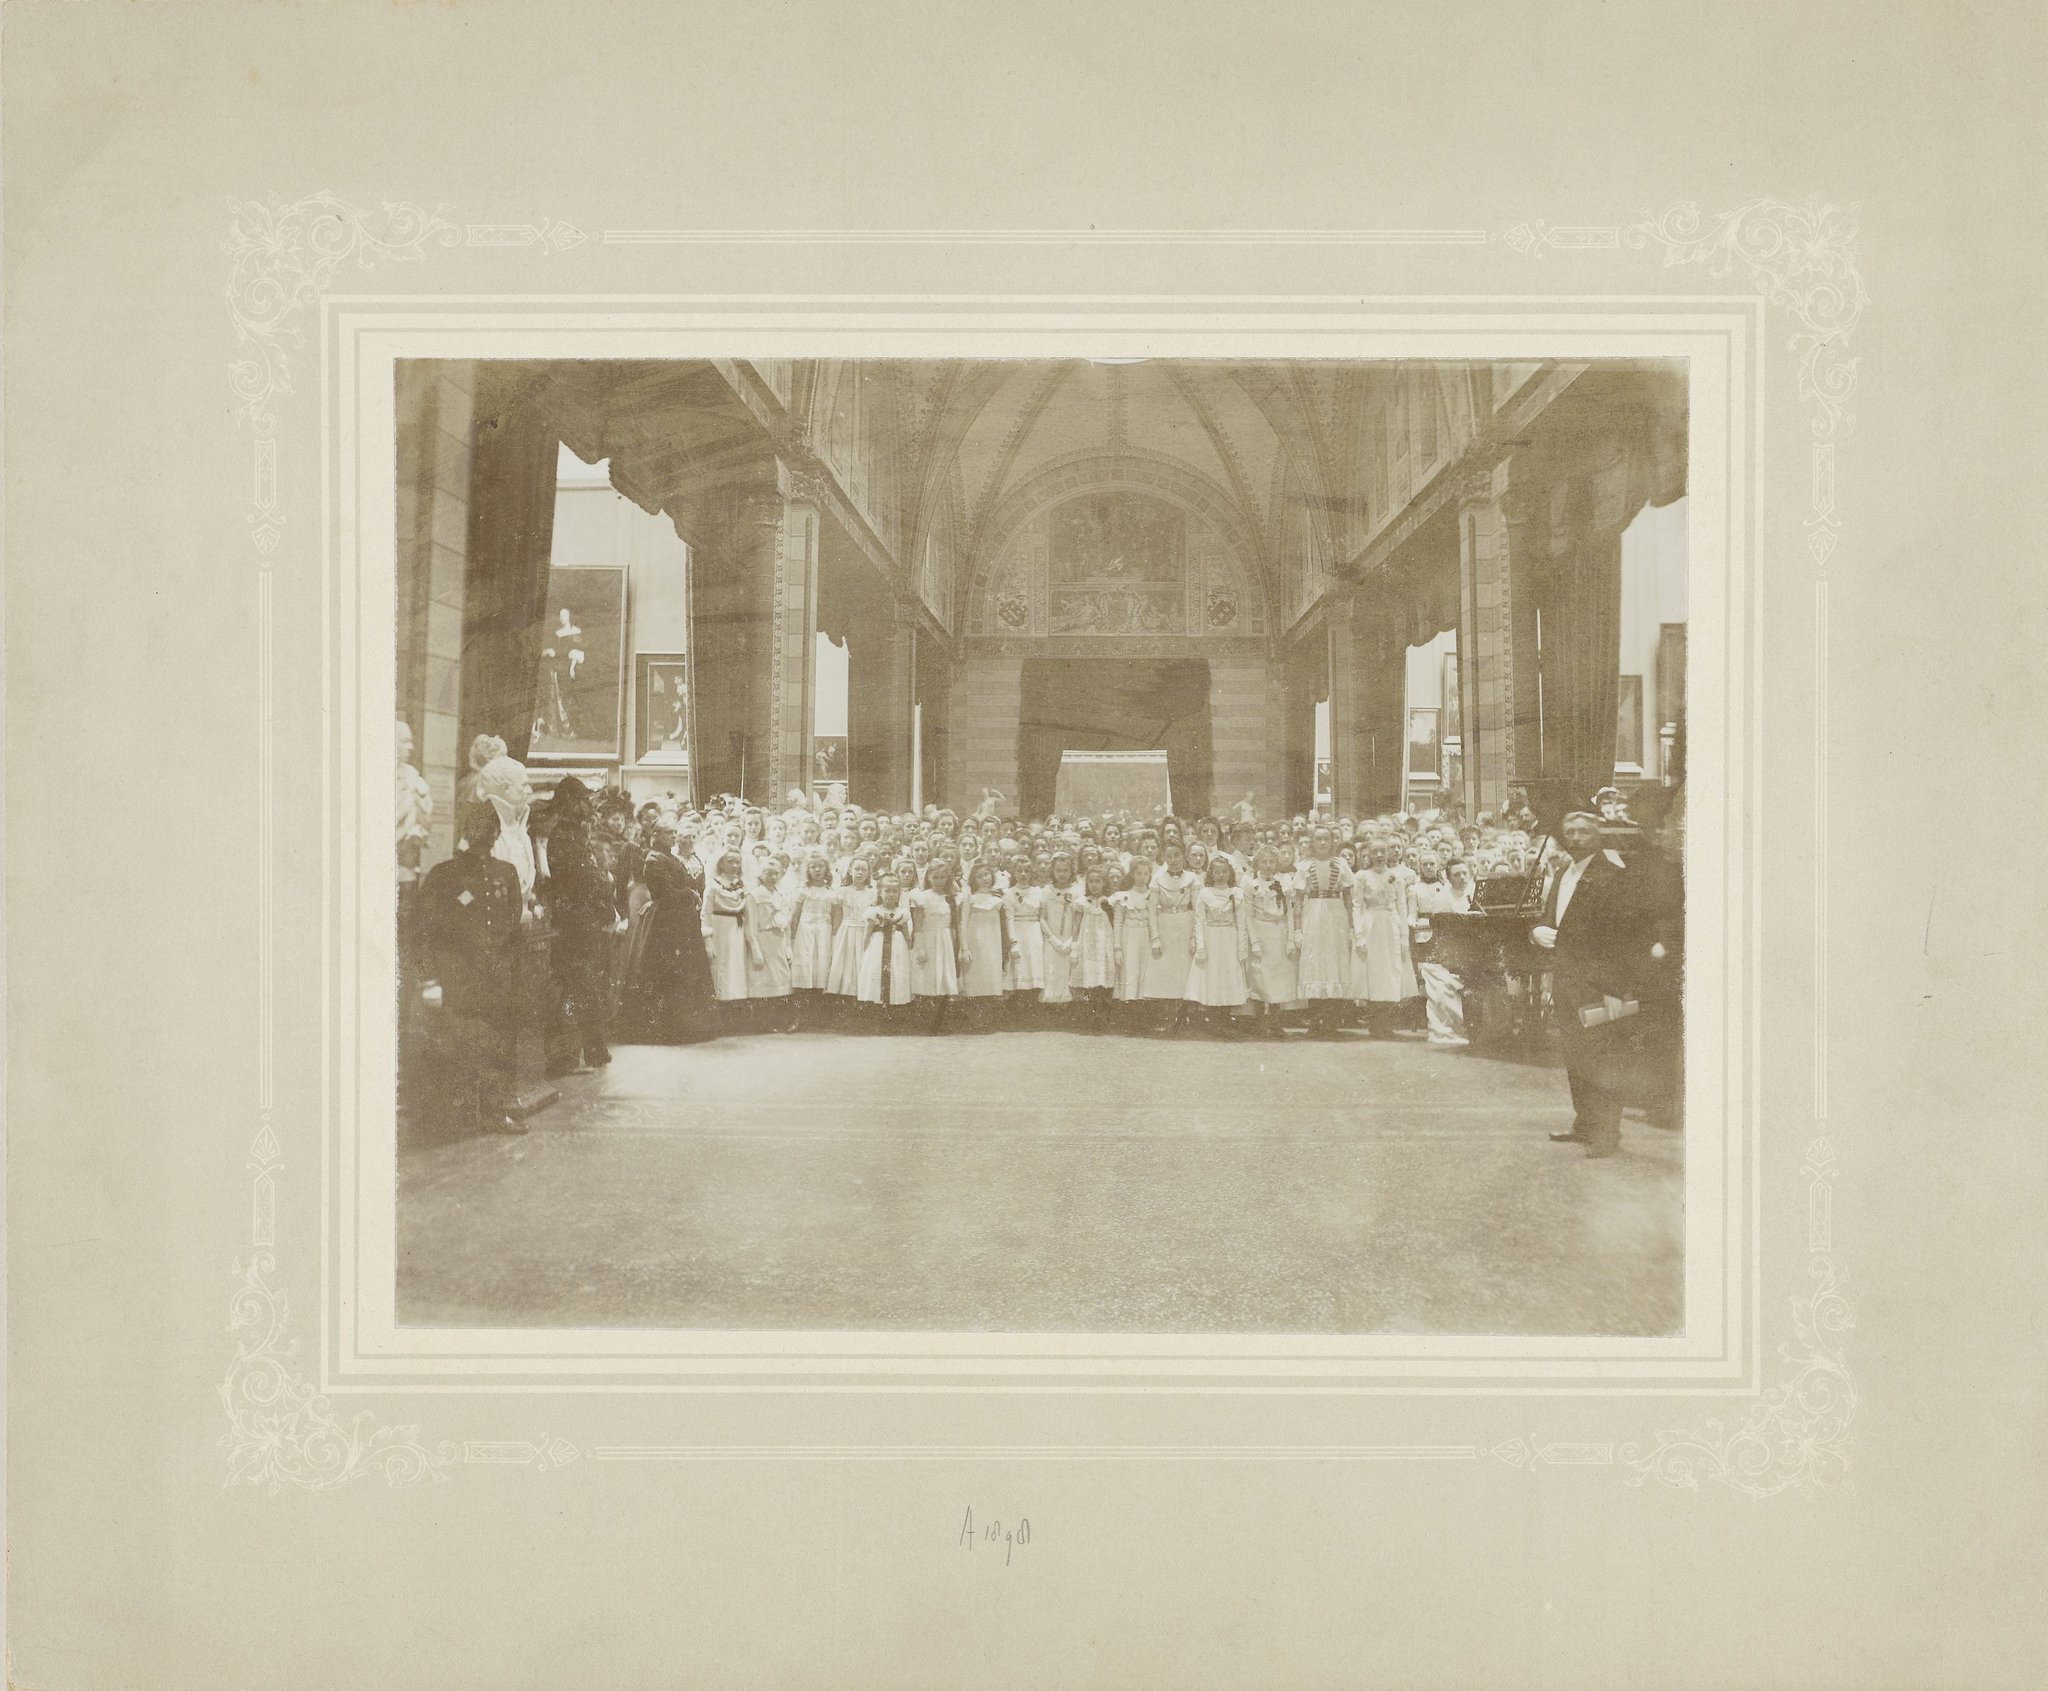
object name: photograph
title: Feestelijkheden ter gelegenheid van de inhuldiging van Koningin Wilhelmina: koorzangeresjes in het Rijksmuseum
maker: Anonymous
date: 1898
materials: cardboard, paper, photographic support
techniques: albumen print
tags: the hague, print maker, wilhelmina of the netherlands, permanent exhibition, museum, choir, installation of a ruler, historical events and situations